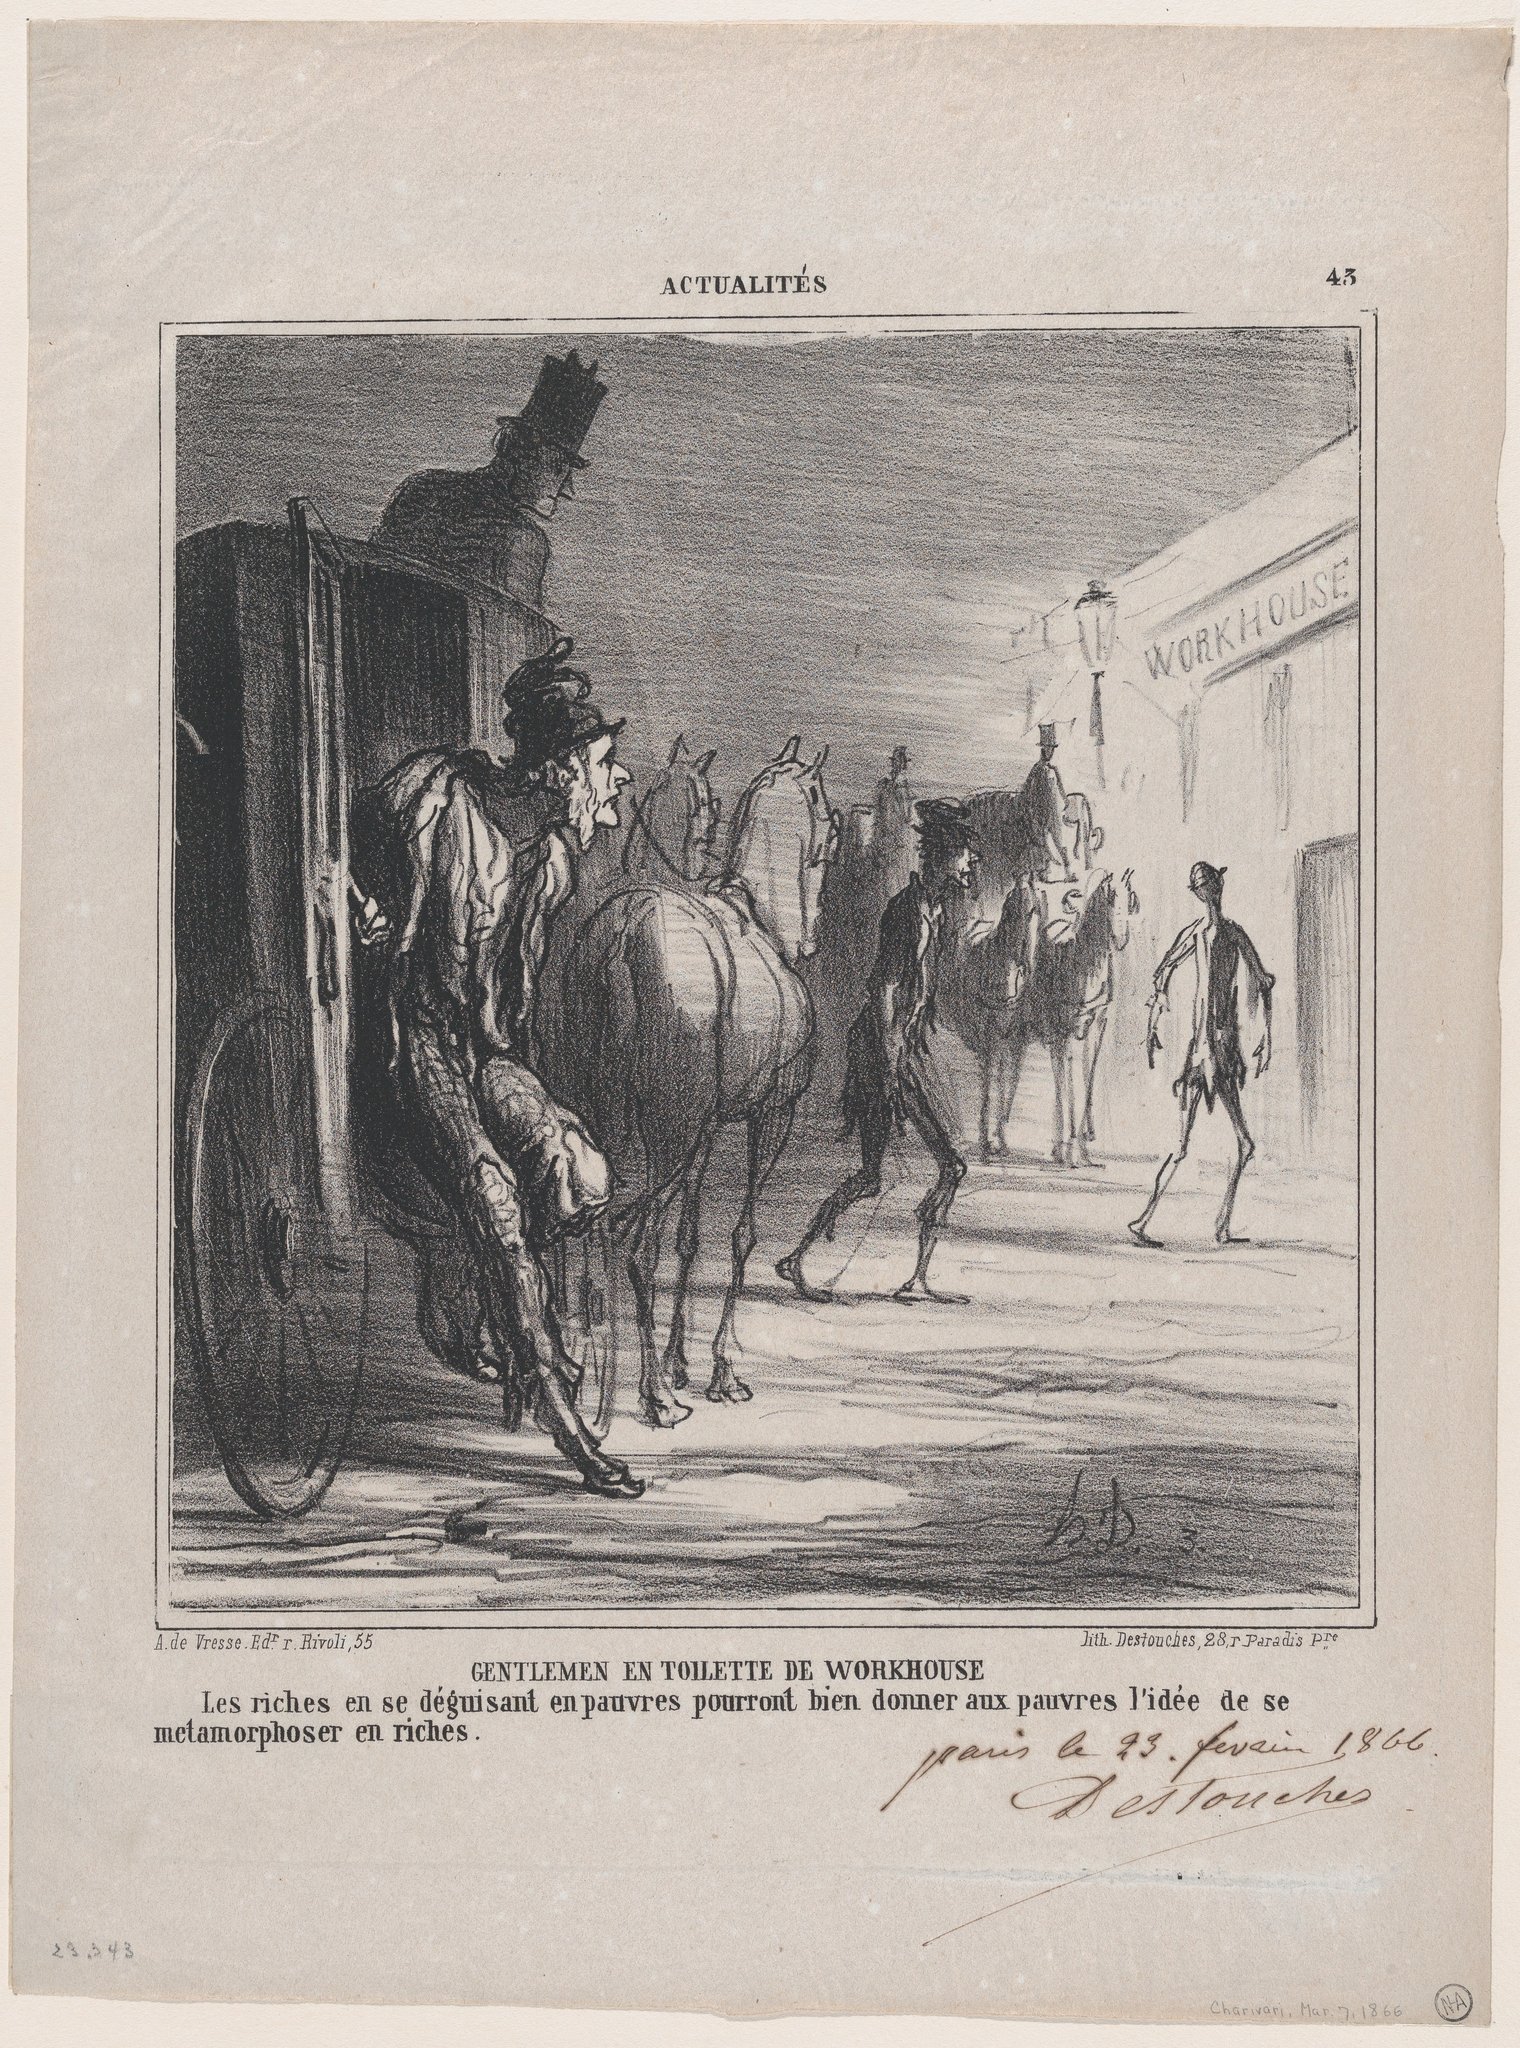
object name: print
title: Gentlemen in workhouse clothes: If the rich are disguising themselves as poor, one might get the idea that the poor might transform themselves into the rich, from 'News of the day'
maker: honoré daumier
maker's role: artist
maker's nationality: french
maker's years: 1808-1879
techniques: lithograph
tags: satire,men,horses,carriages